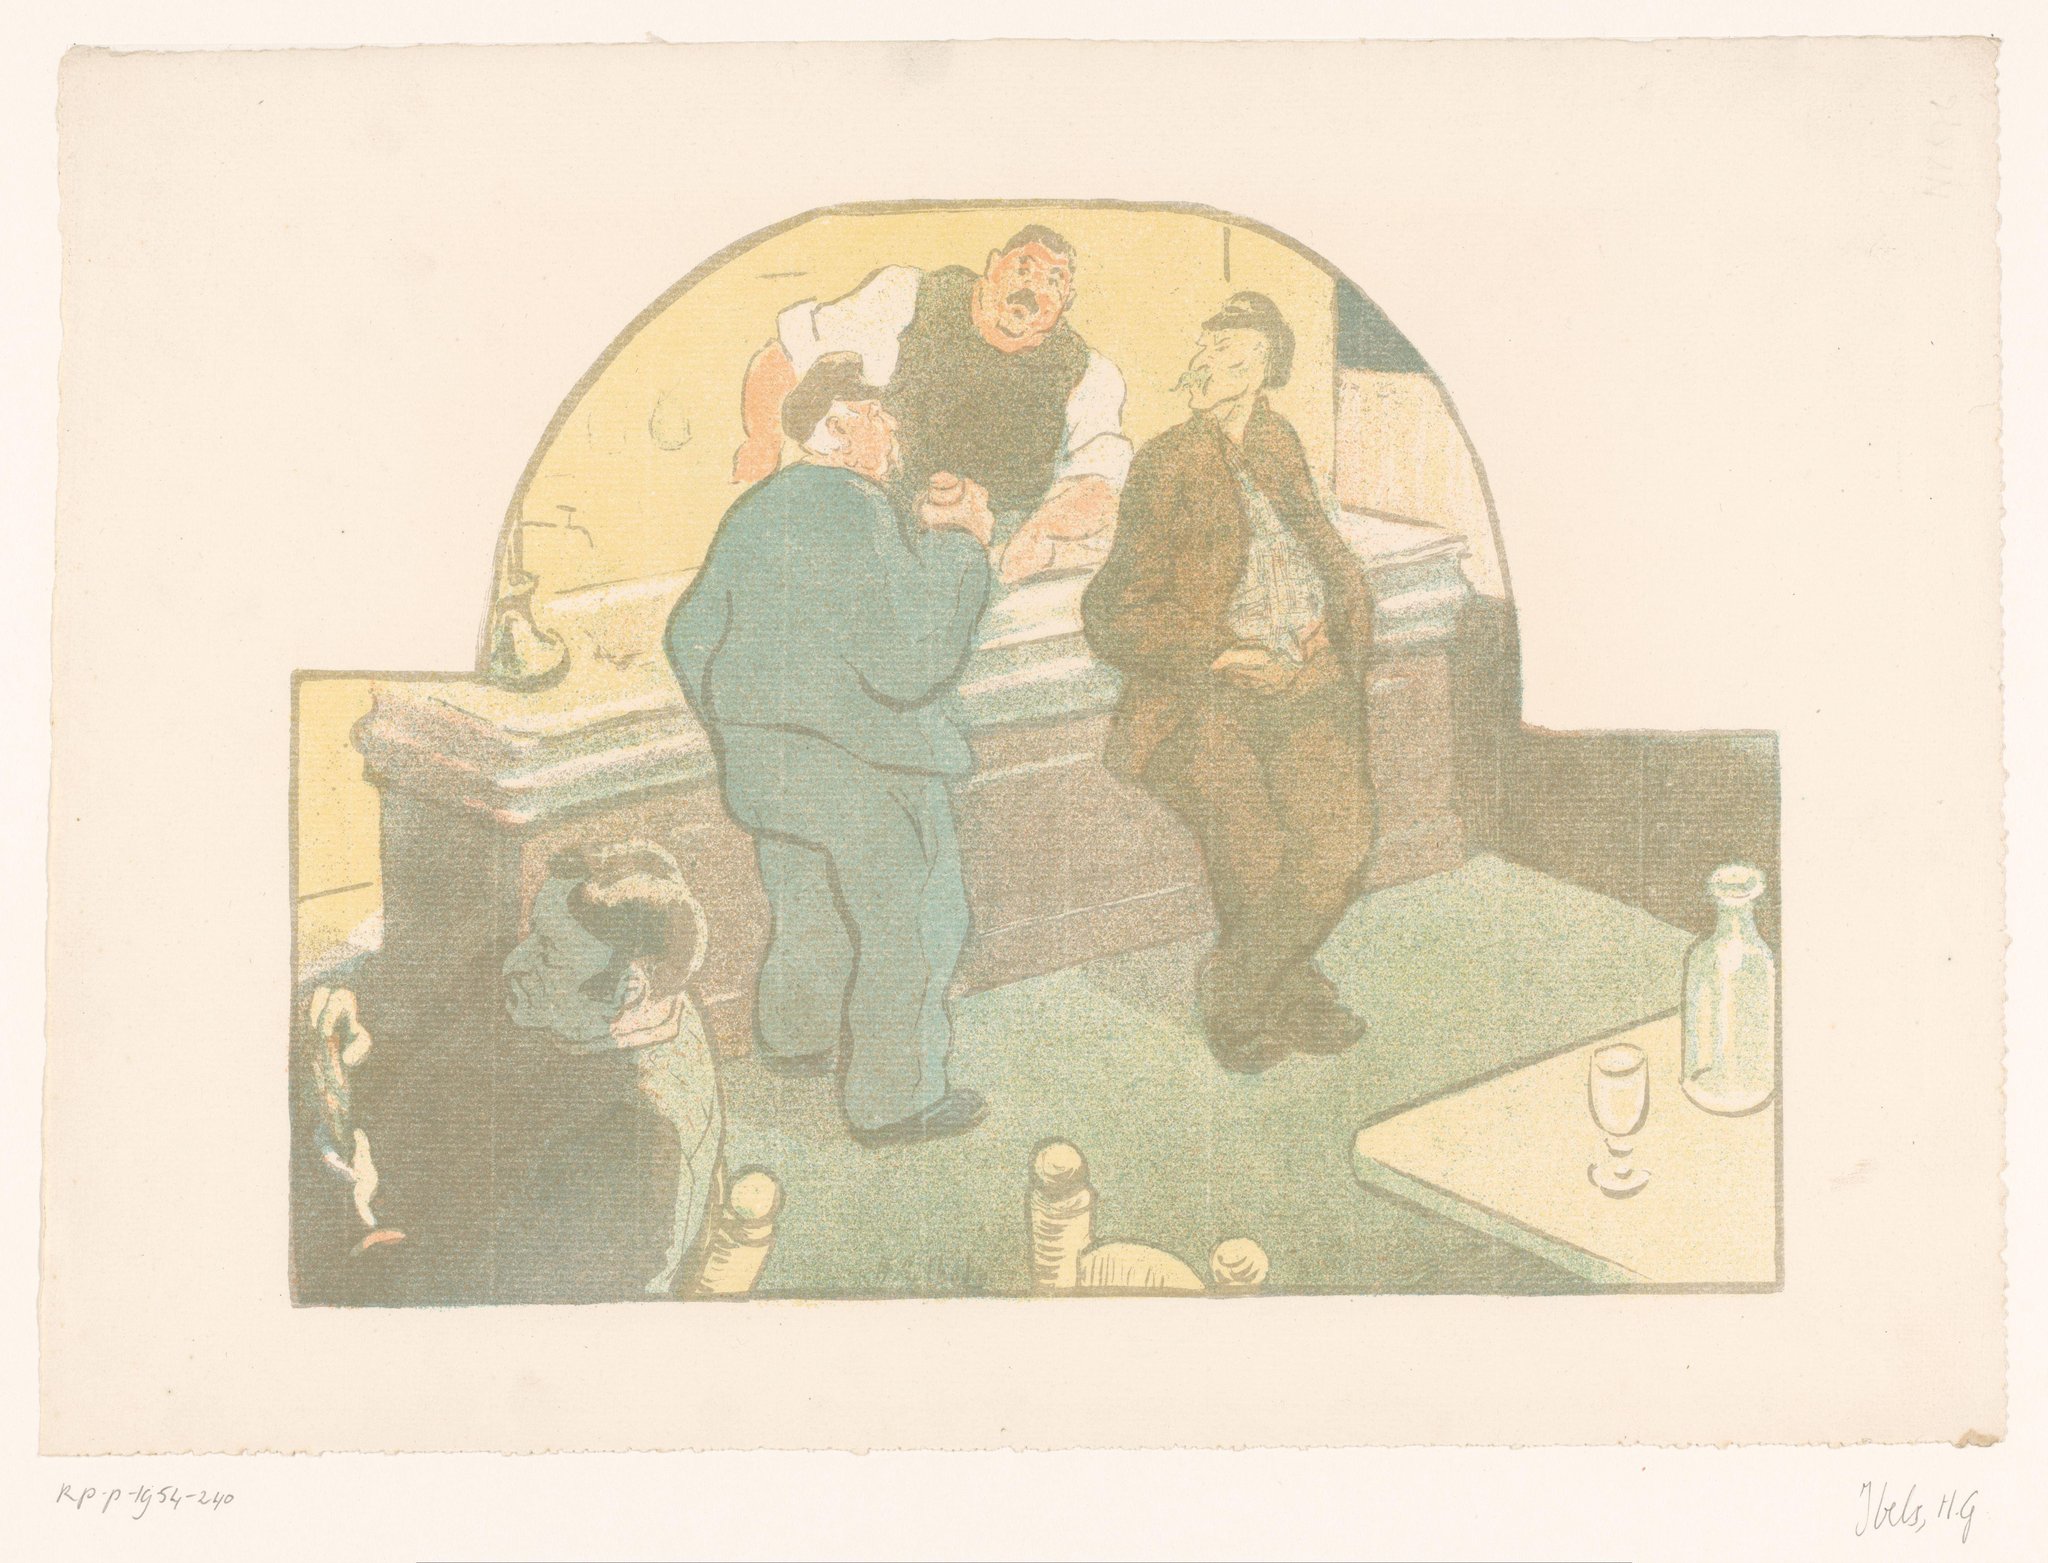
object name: print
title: Voorstellingen van het Théâtre Libre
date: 1892-1893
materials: paper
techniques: lithograph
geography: paris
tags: inn, coffee-house, public house, etc., alcoholic drinks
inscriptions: date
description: Ontwerp voor het programma van de theatervoorstelling Le Devoir van het Théâtre Libre (4e spectacle).